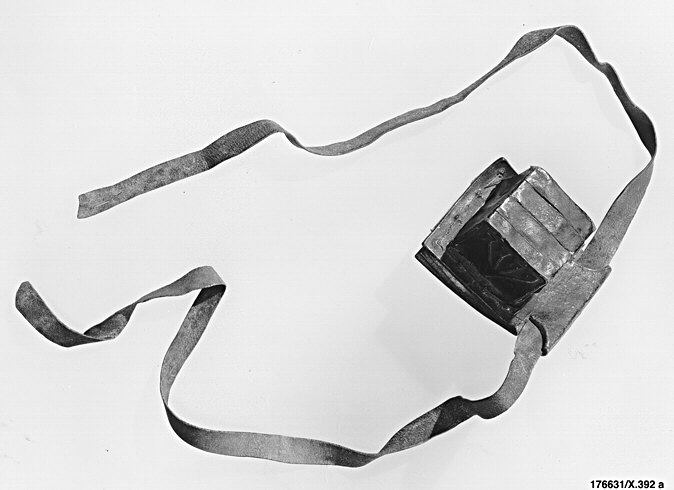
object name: phylactery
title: Phylactery (tefillin)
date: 1801-1900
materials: leather, parchment, wood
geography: egypt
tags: amulets